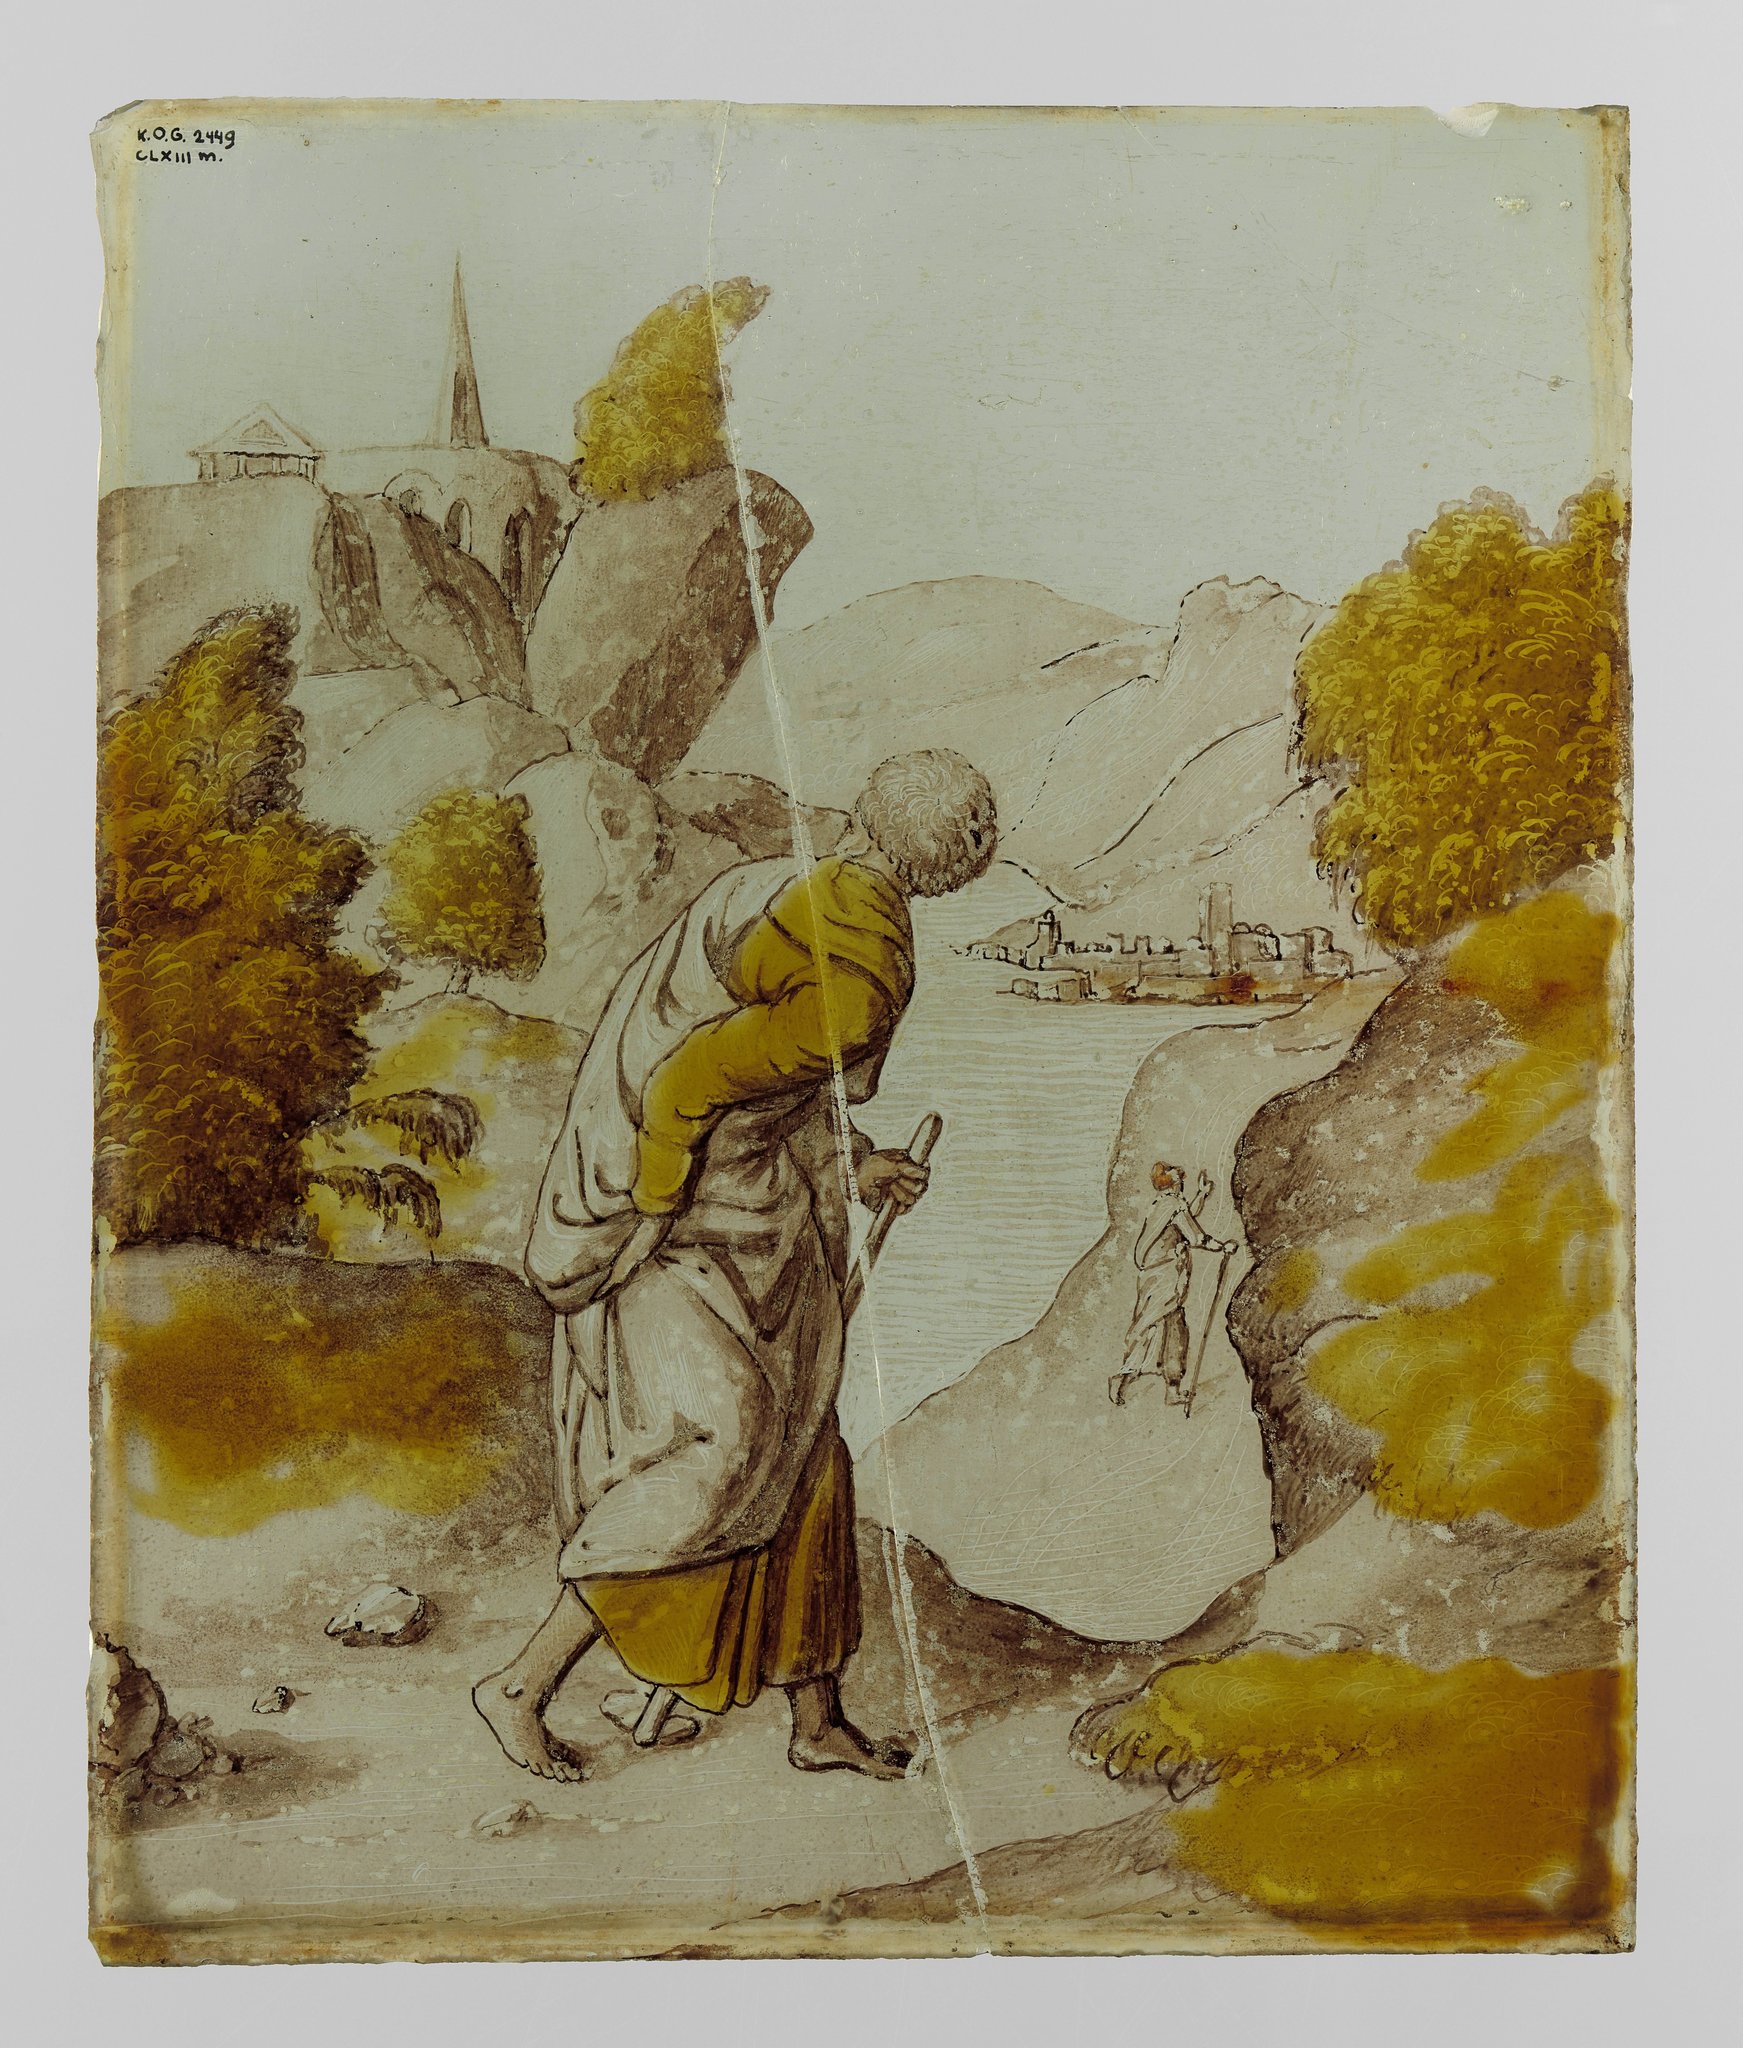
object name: light window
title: Ruit, rechthoekig, met afbeelding van twee wandelende mannen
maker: Anonymous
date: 1500-1550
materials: glass, lead, pigment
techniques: leading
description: Rechthoekige gebrandschilderde ruit in bruin en geel waarop afgebeeld twee wandelende mannen. Opmerking: Onderdeel van de groep BK-CLXIII-a t/m r.